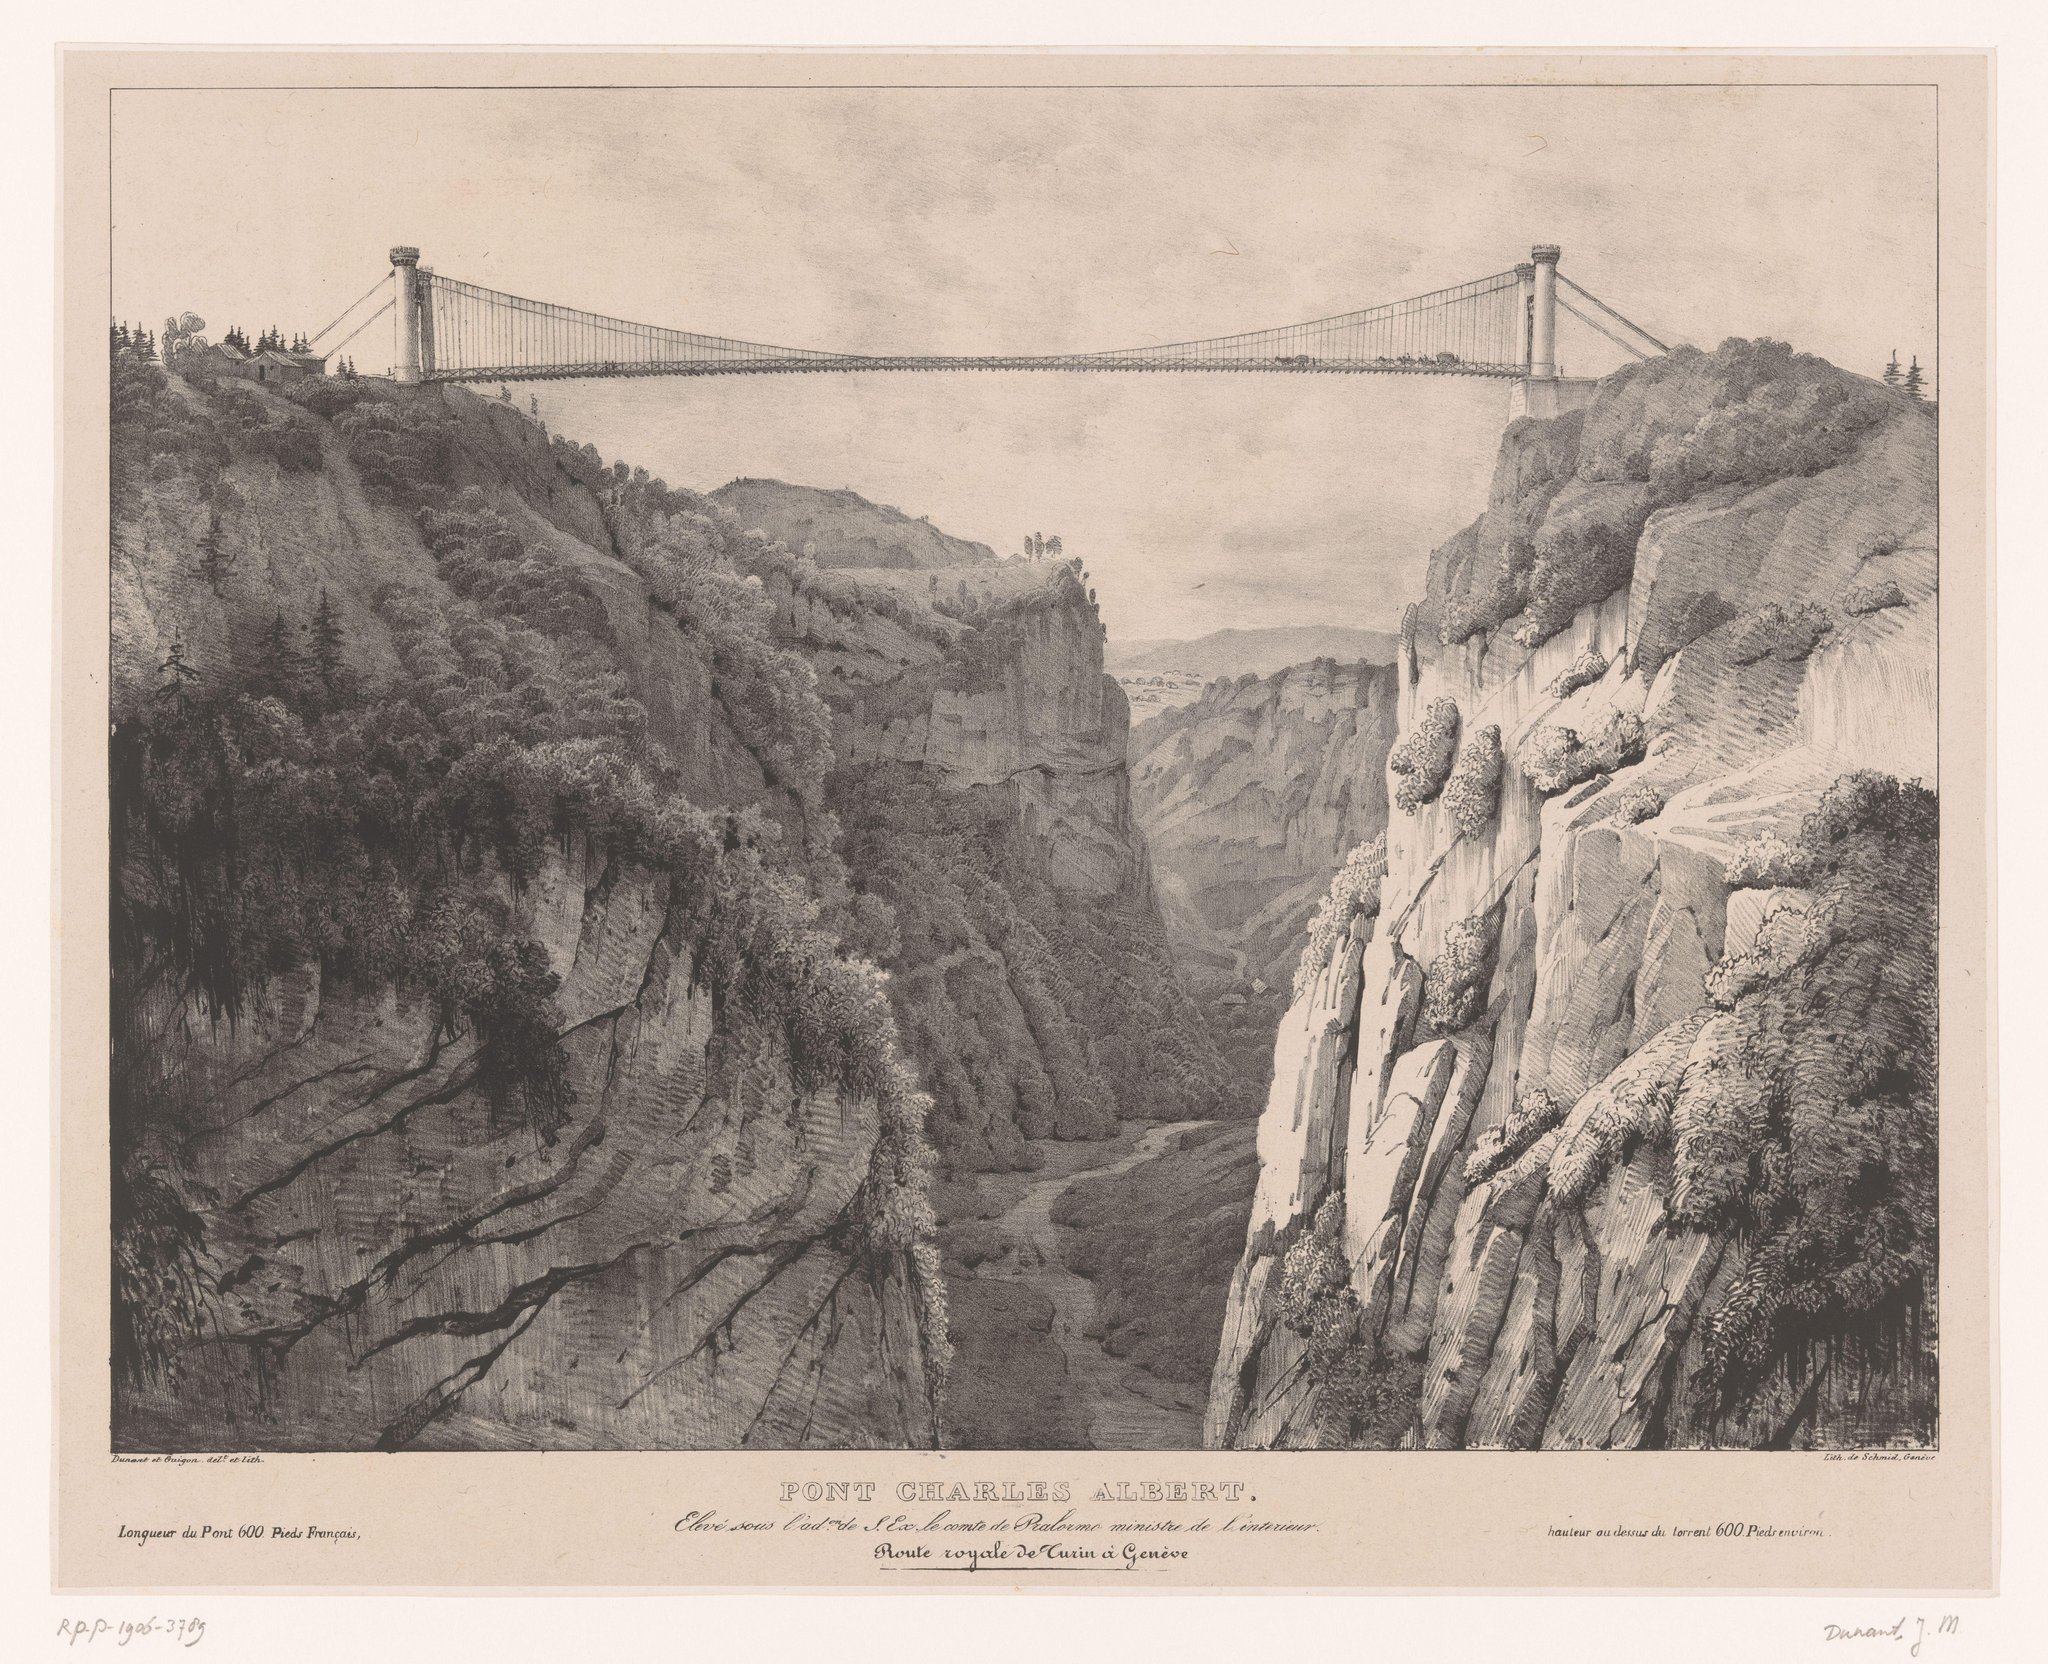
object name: print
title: Pont Charles Albert. Route royale de Turin à Genève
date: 1828-1882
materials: paper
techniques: lithograph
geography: geneva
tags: suspension bridge, ravine, chasm, abyss, canyon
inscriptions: collector's mark: Lugt 2228a